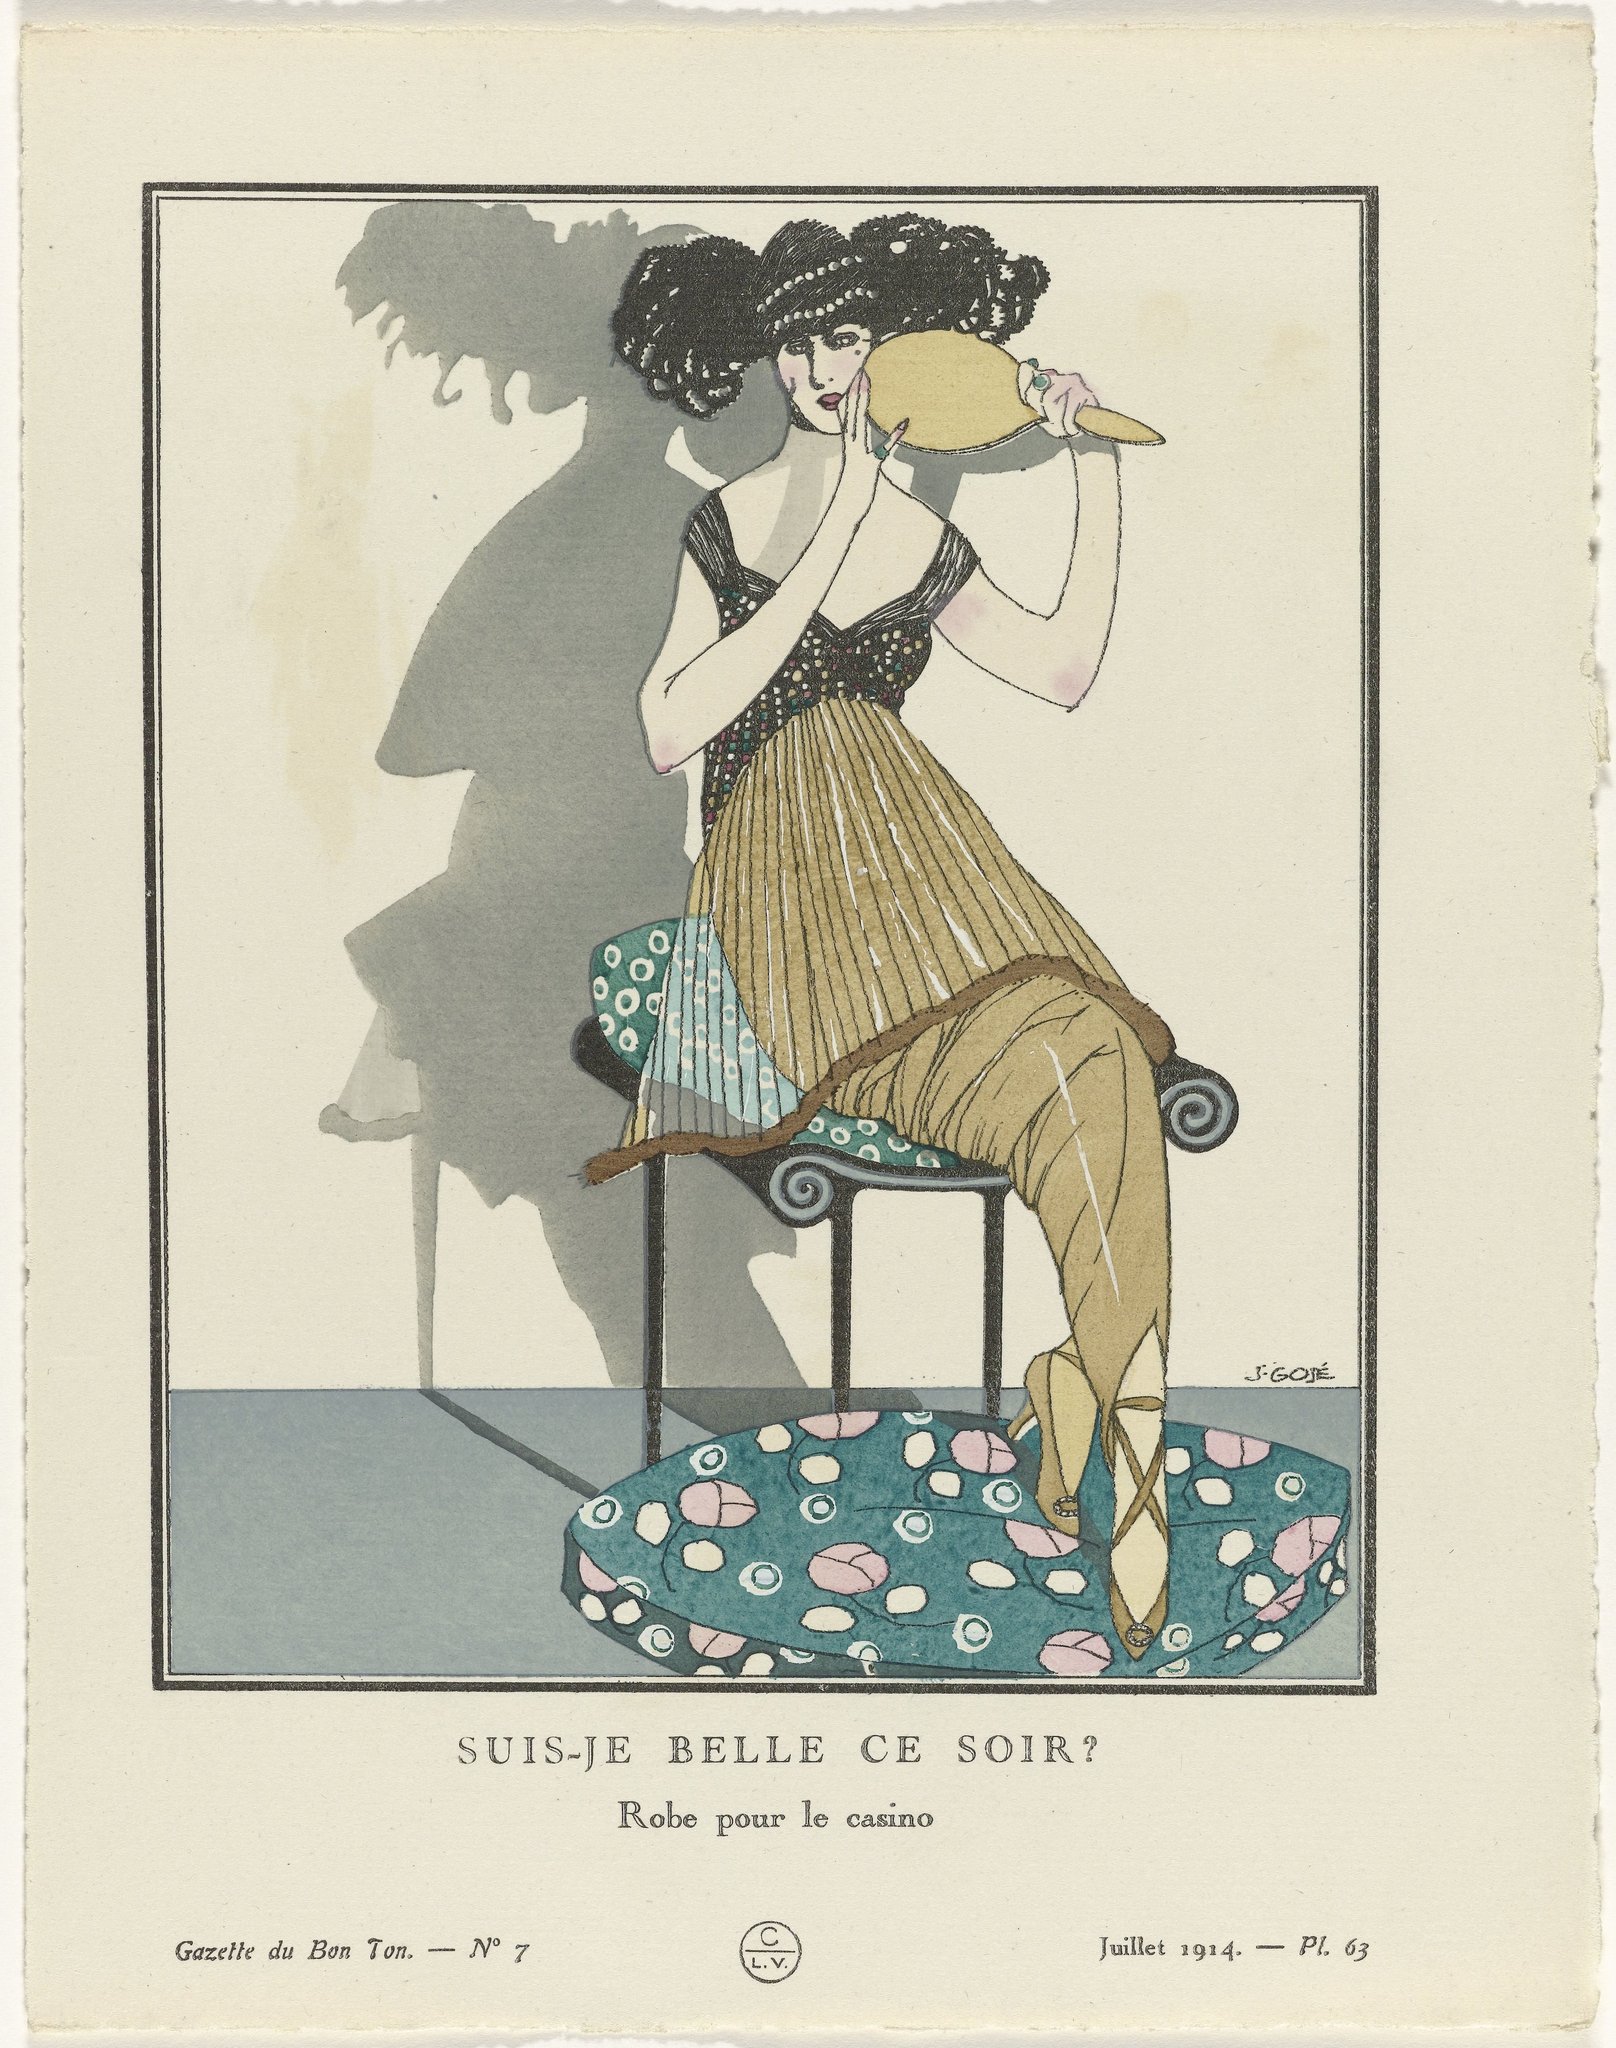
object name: fashion print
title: Gazette du Bon Ton. Art – Modes & Frivolités: Artists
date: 1914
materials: paper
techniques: hand coloring, letterpress printing, lithograph, pochoir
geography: paris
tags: ring (+ women's clothes), mirror, fashion plates, dress, gown (+ women's clothes), pillow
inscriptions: date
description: What set this fashion magazine ‘of good taste, art and frivolity’ apart was its unique collaboration with the artists who produced its illustrations. As well as drawing the haute couture of the fashion houses, they were also granted space in each issue to present designs of their own making. In each issue, three out of ten plates were reserved for such independent creations.